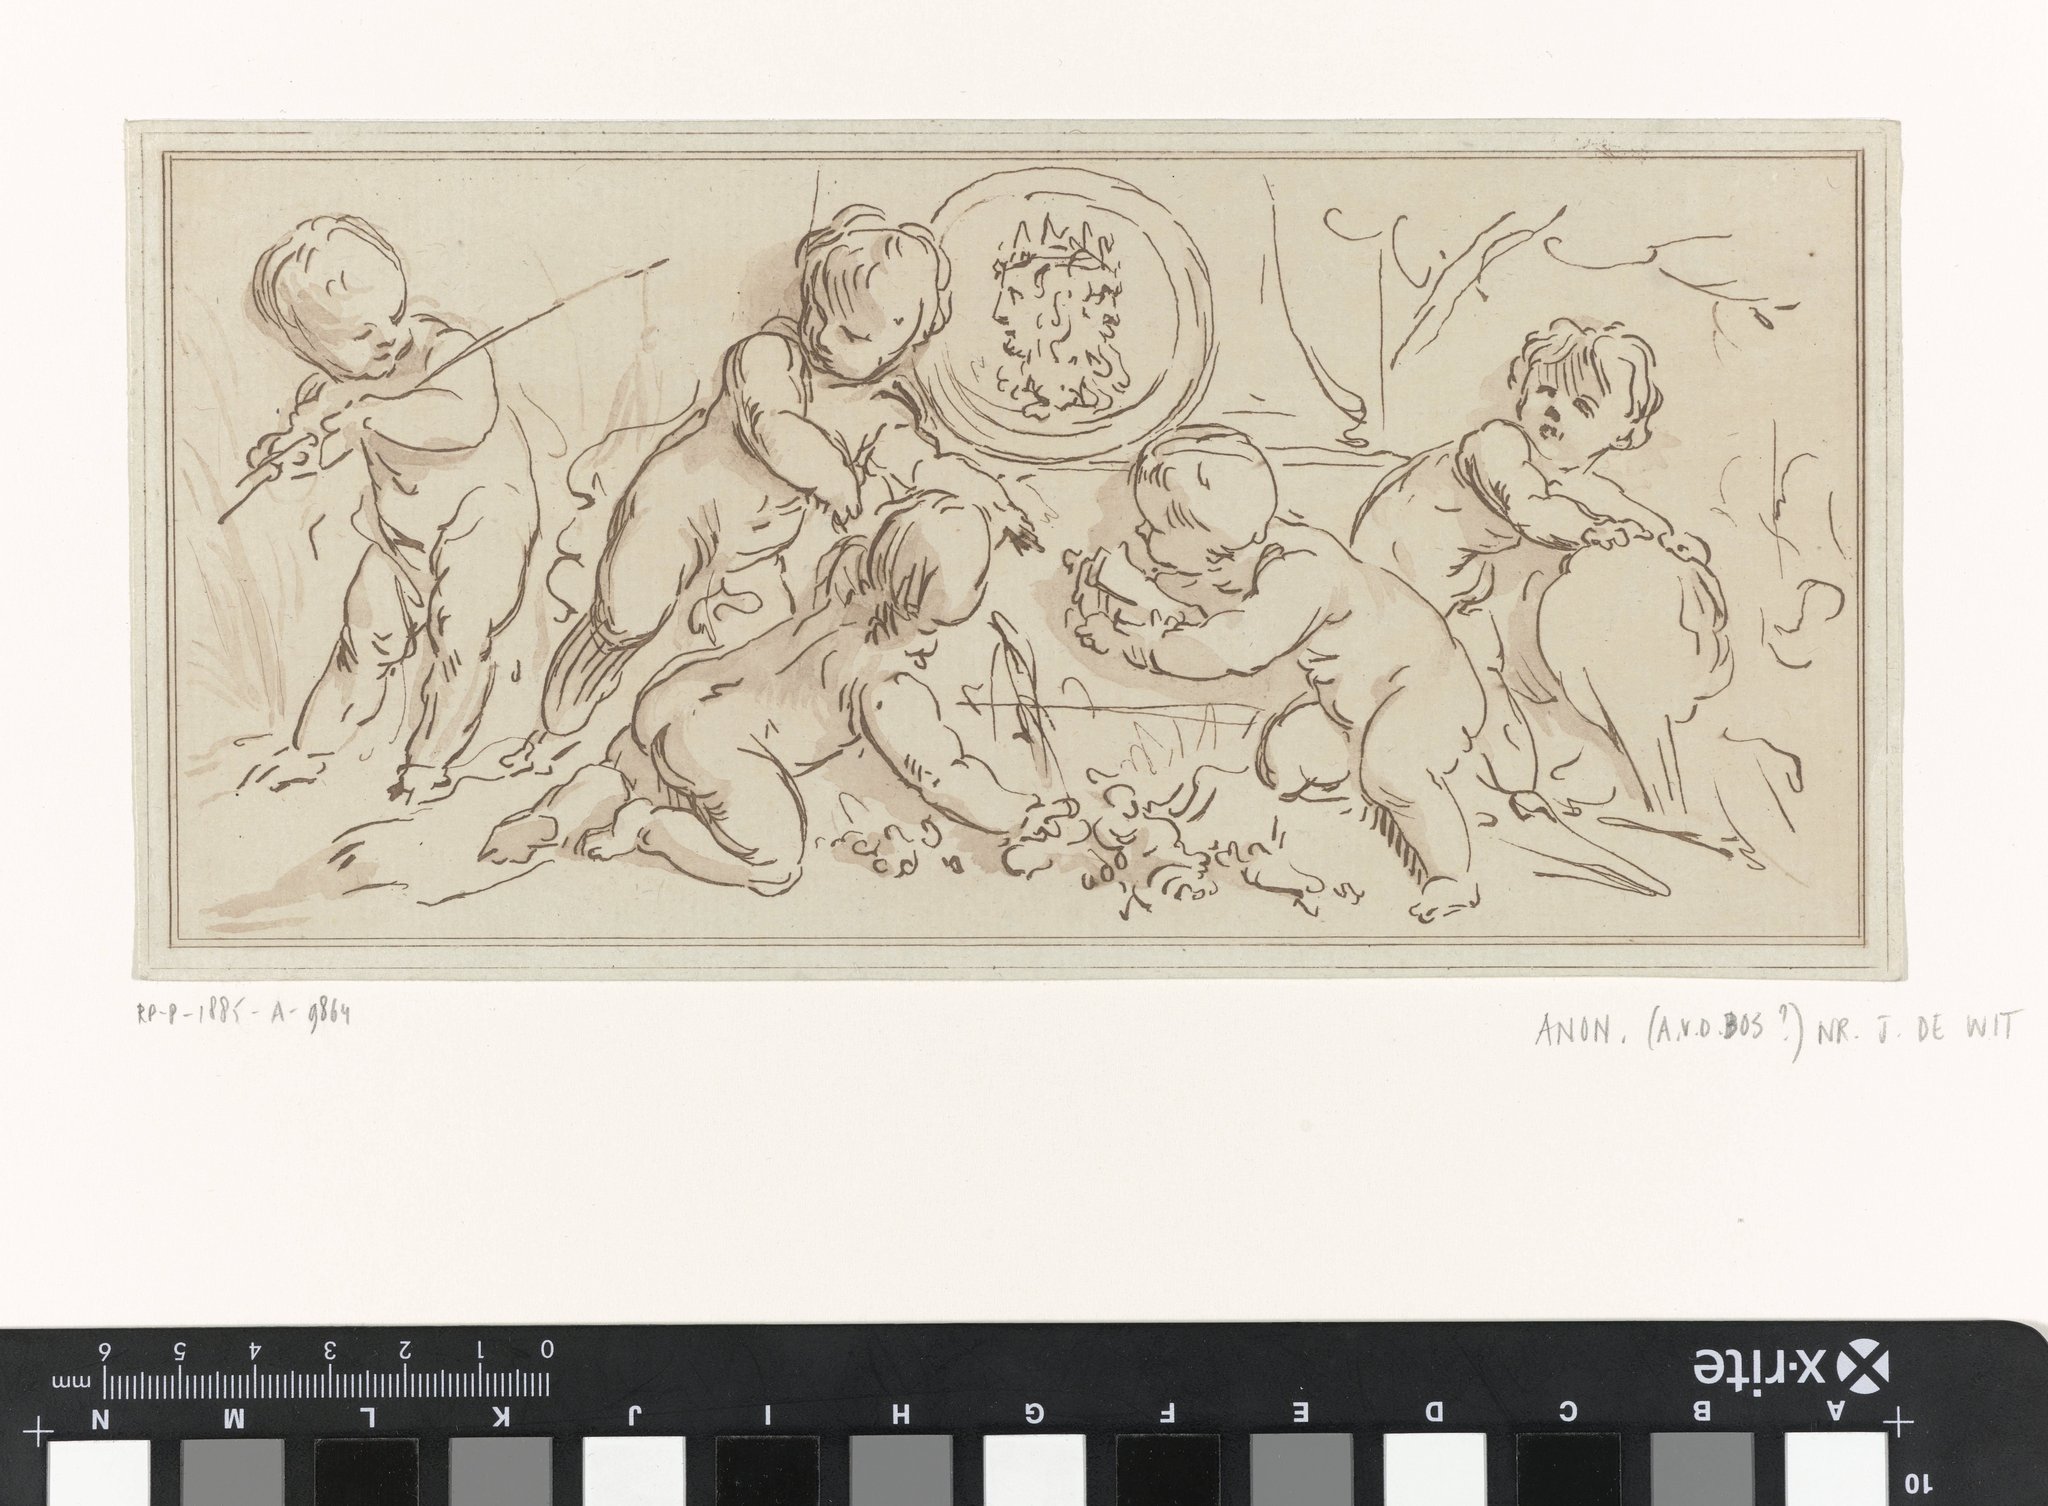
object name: print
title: Vijf putti bij een monument met Januskop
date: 1778-1838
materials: paper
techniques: aquatint, etching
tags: cupids: 'amores', 'amoretti', 'putti'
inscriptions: collector's mark: Lugt 2228, collector's mark: Lugt 2610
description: Putti bij een monument met een basreliëf versierd met een Januskop.